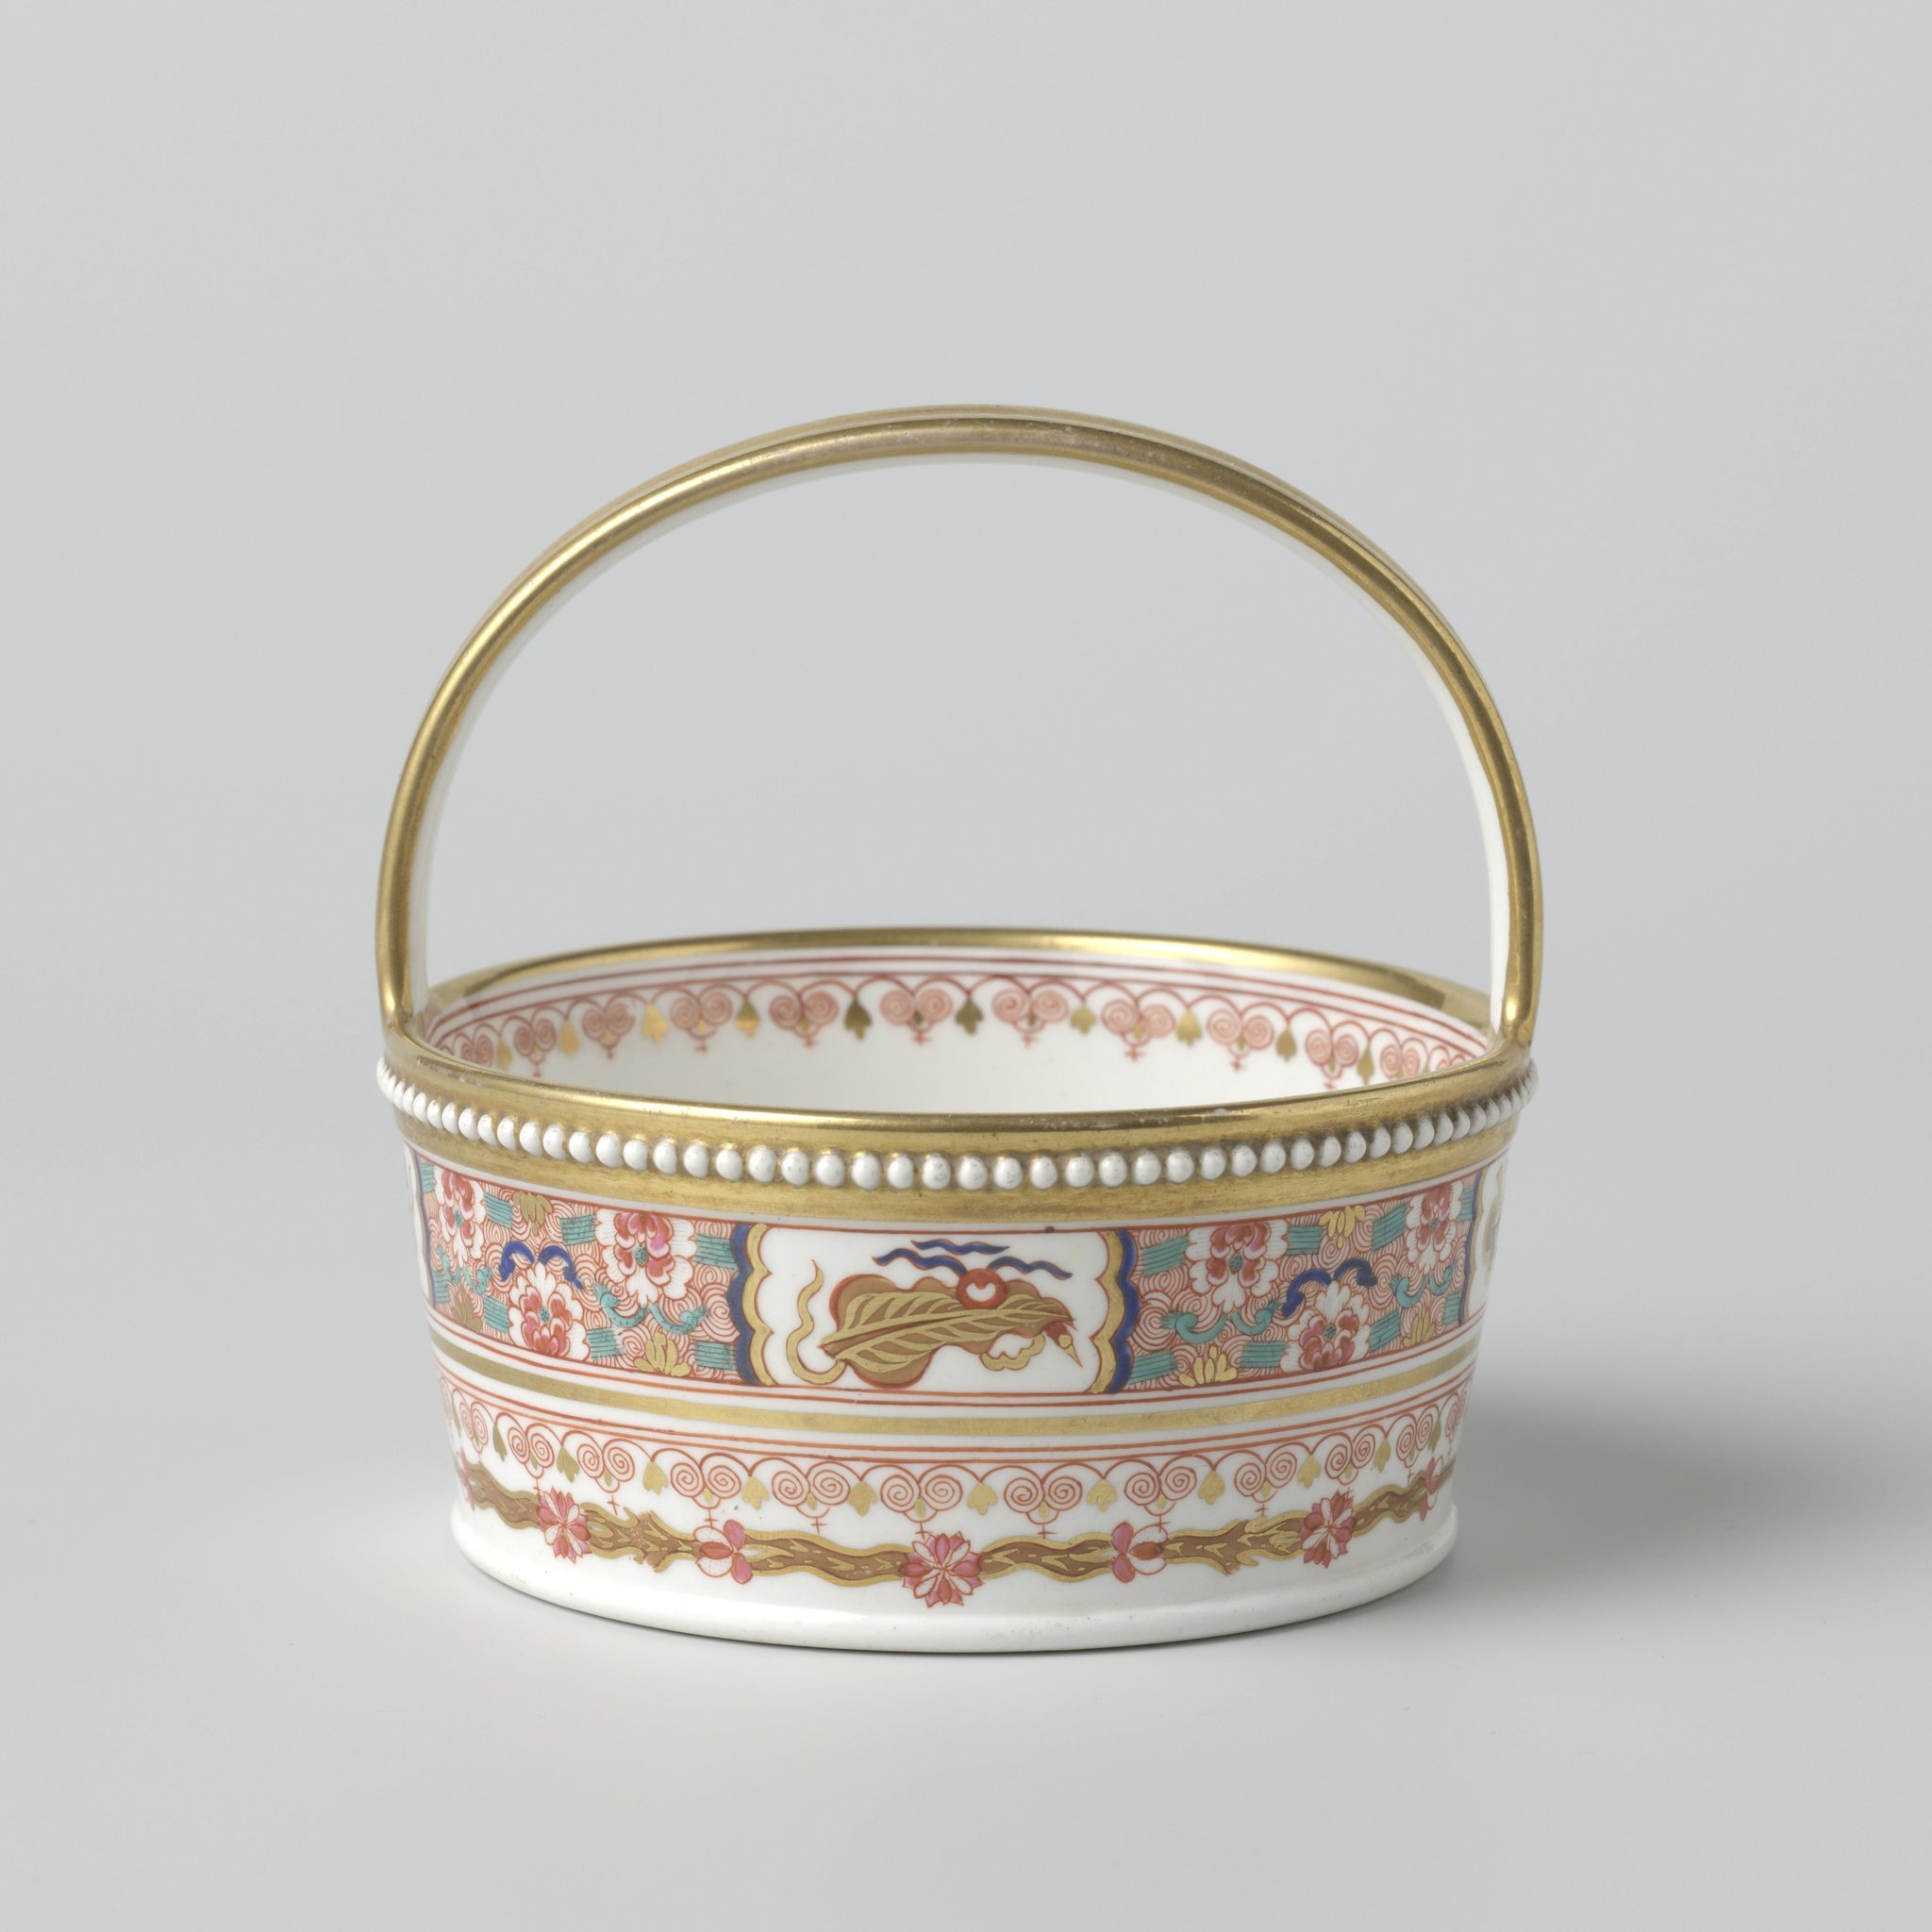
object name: container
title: Hengselbak met Chinese motieven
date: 1790-1800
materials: porcelain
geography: stoke-on-trent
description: Hengselbak van wit porselein, versierd met Chinese motieven in rood, goud, turkoois, blauw en geelbruin. Het hengsel is verguld. Aan de bovenrand van het bakje een rij witte parels in reliëf.